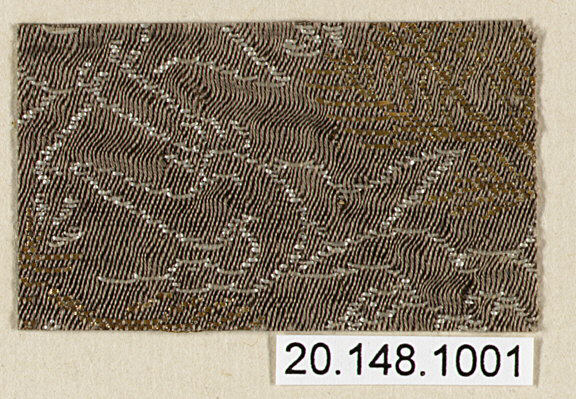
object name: piece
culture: japanese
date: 1801-1900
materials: silk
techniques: compound weave